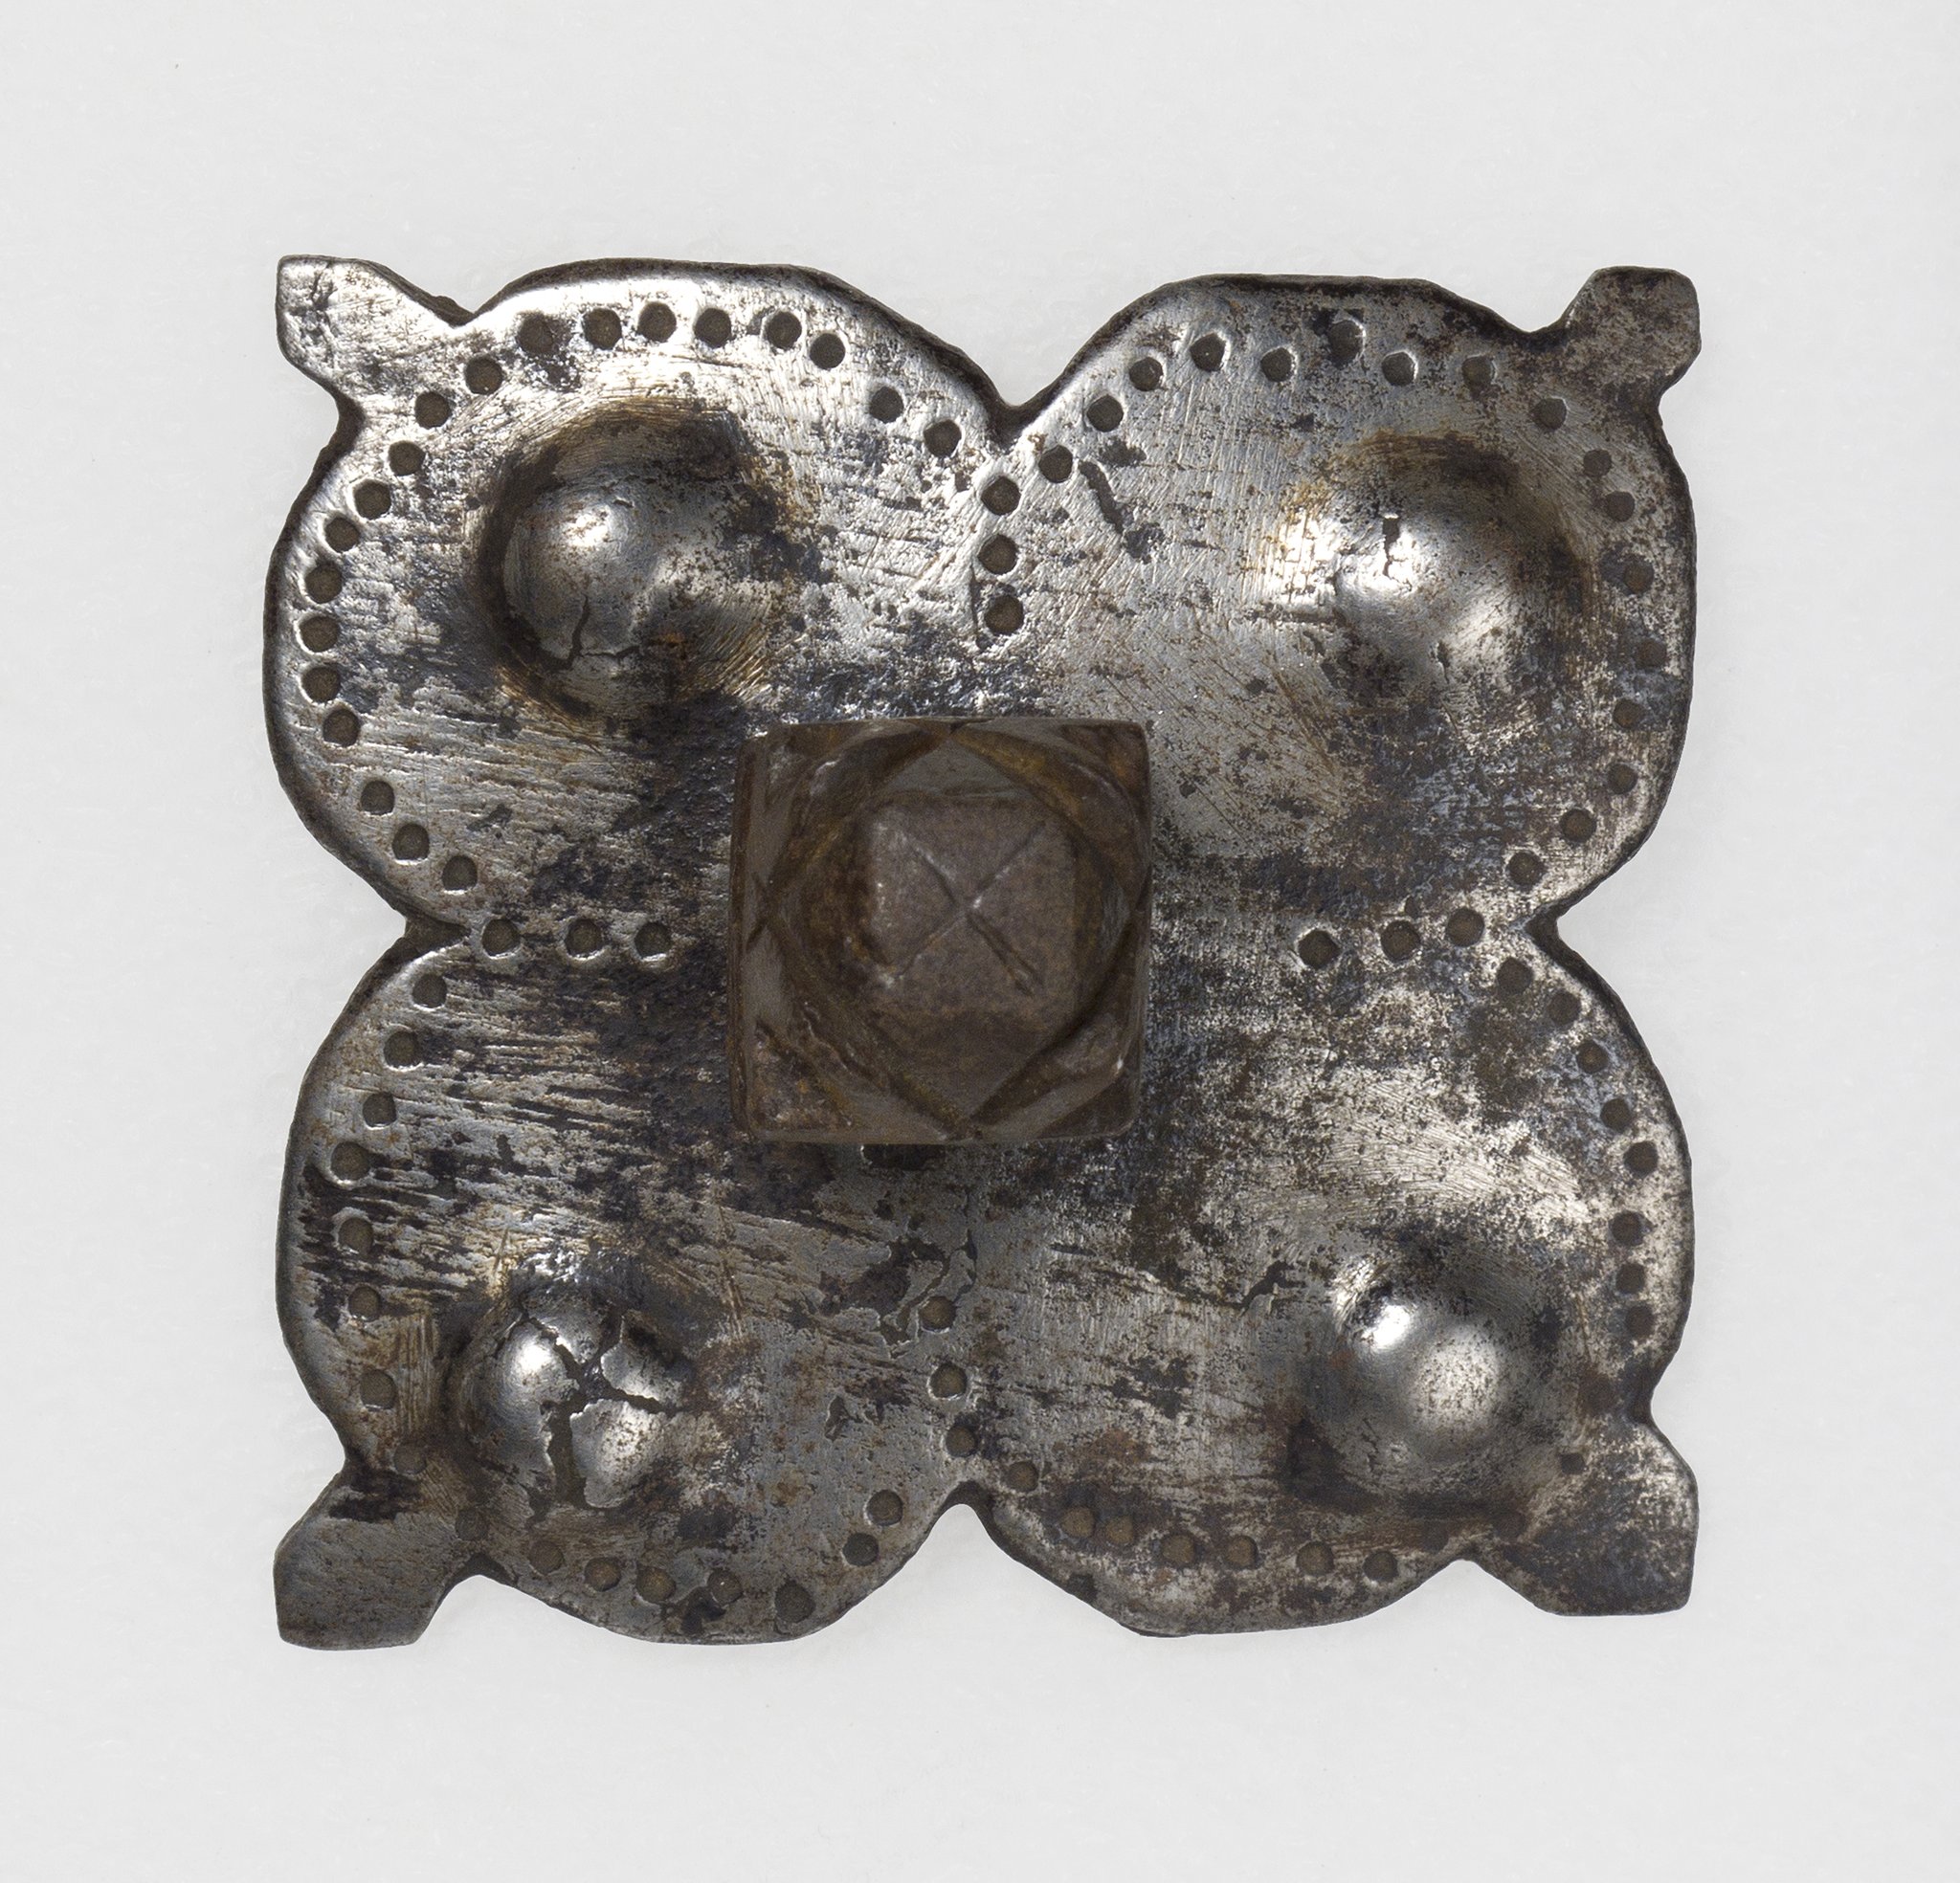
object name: plate and nail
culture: european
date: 1401-1600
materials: iron